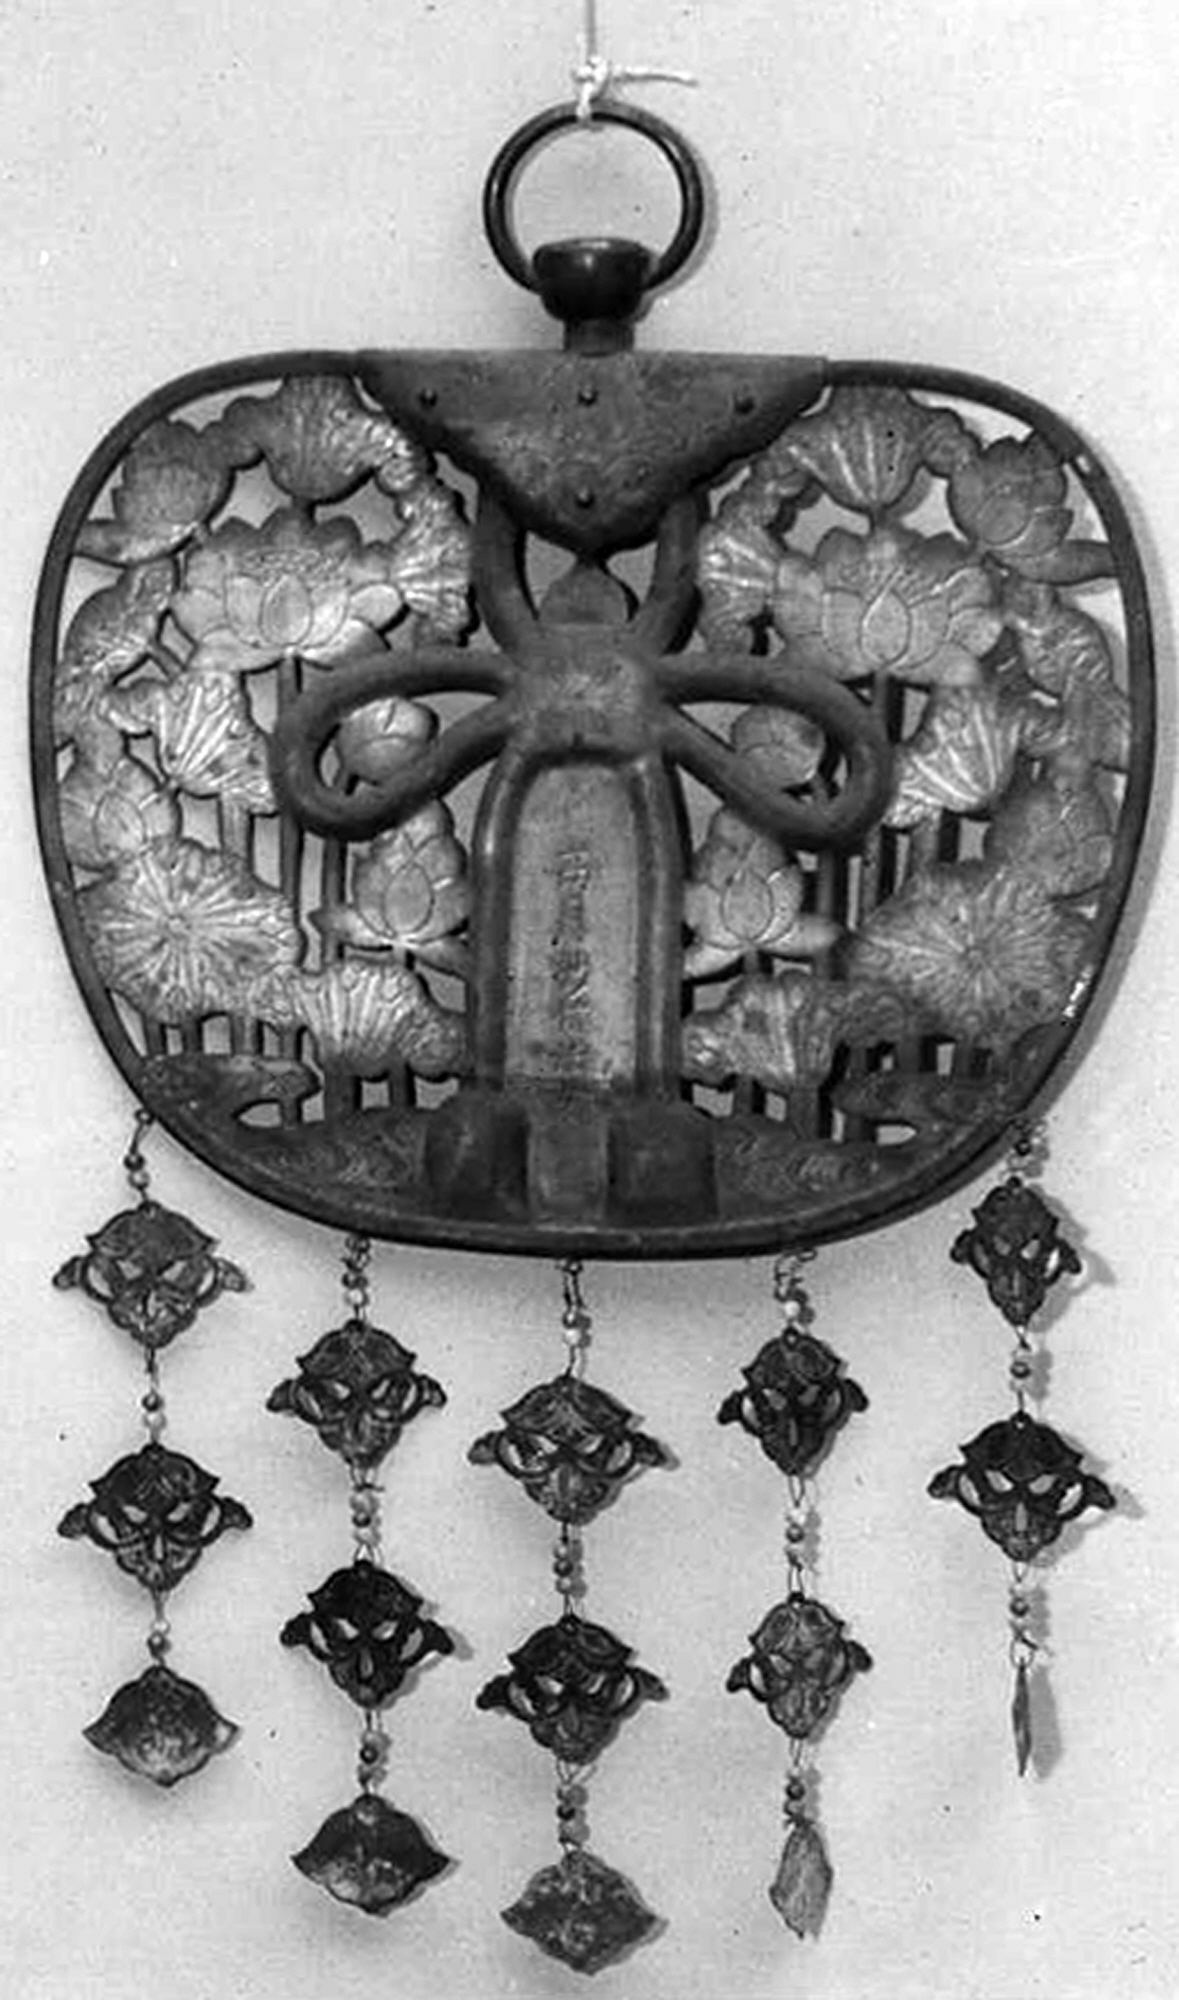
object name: temple hanger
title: Keman (“Flower Garland” Temple Decoration)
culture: japanese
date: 1725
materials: bronze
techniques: gilding